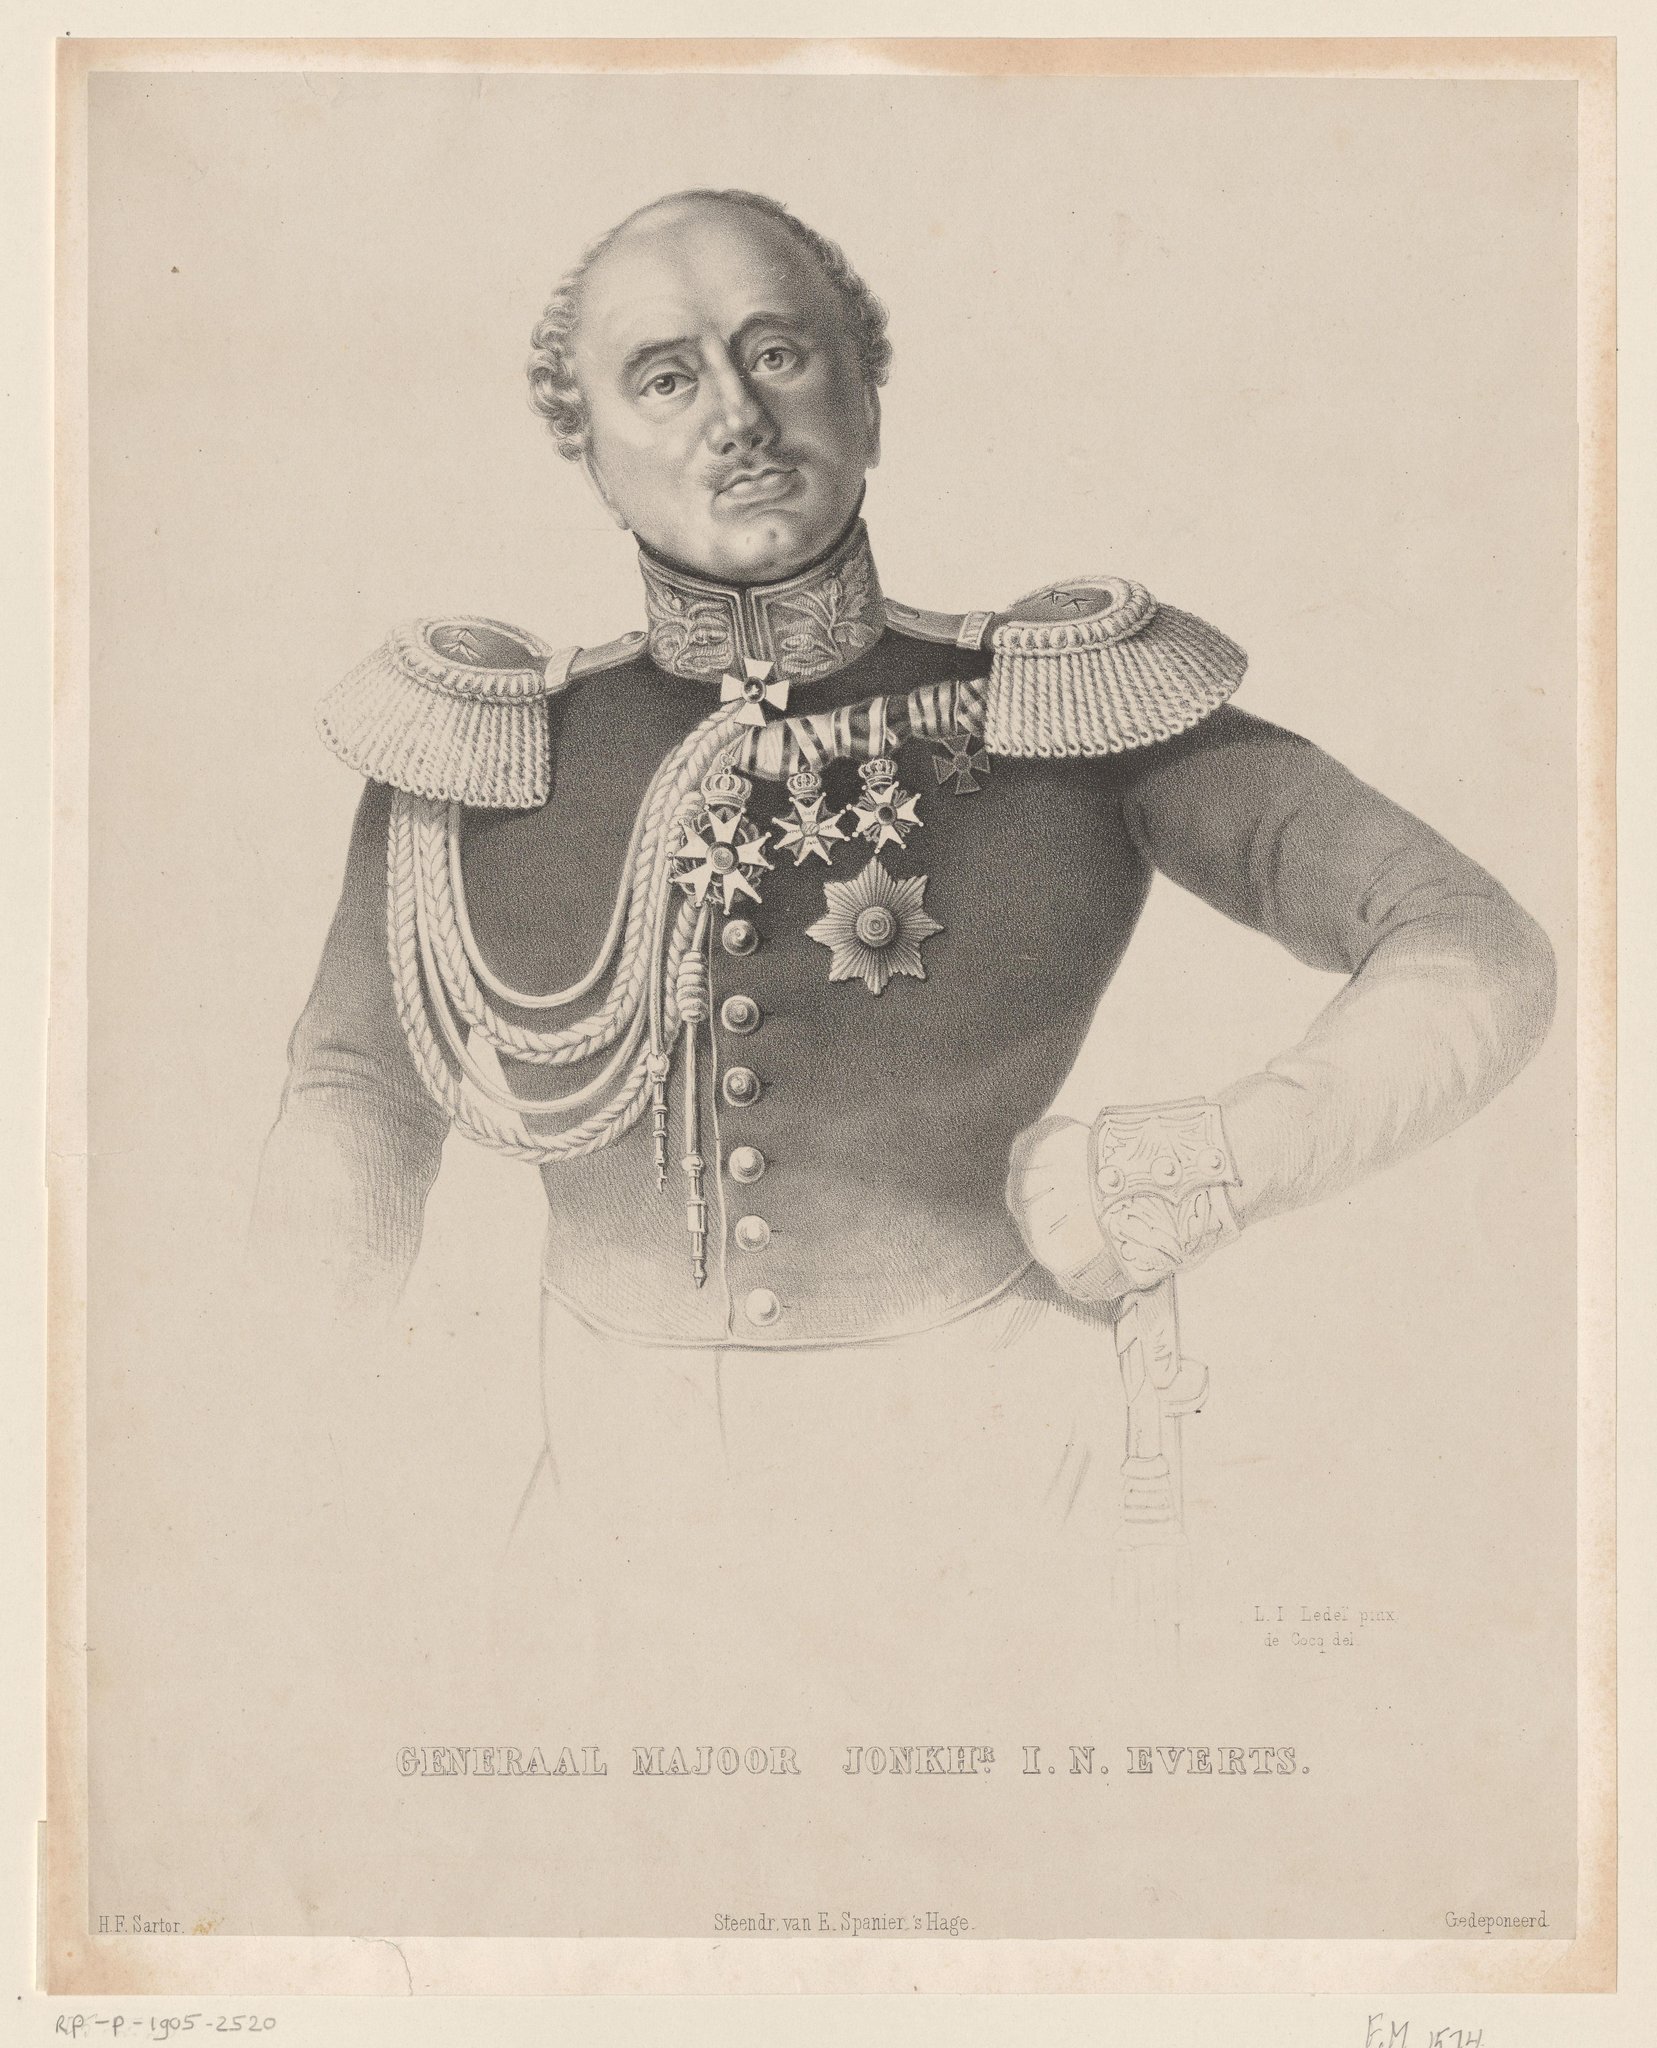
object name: print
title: Portret van Jacob Nicolaas Everts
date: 1843-1853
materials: paper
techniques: lithograph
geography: the hague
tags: the hague, historical persons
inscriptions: collector's mark: Lugt 2228, : ‘Gedeponeerd.’